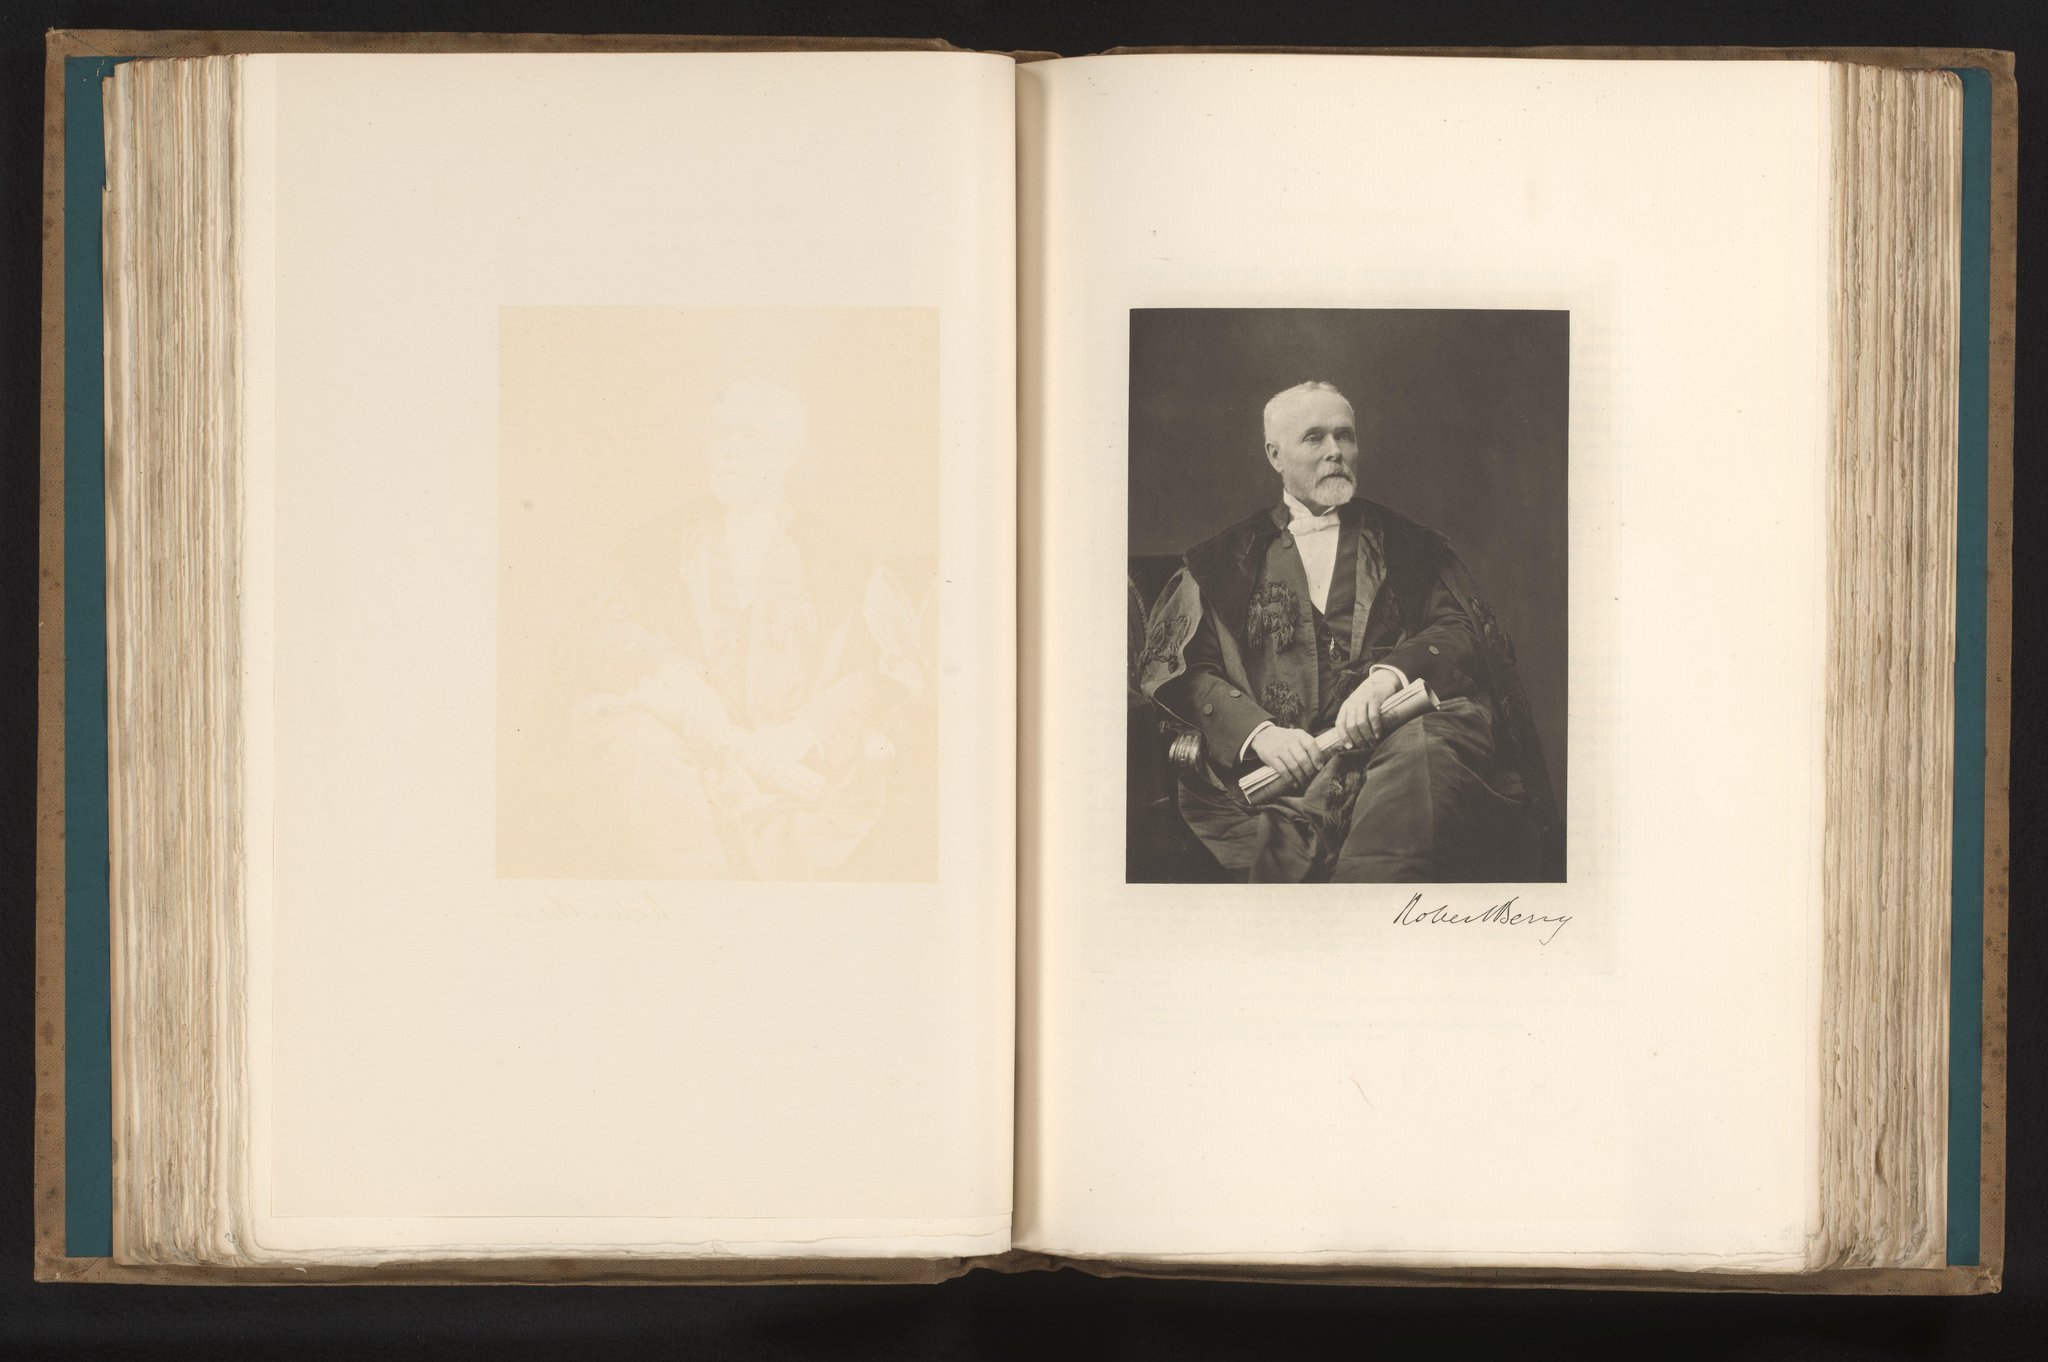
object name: photomechanical print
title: Robert Berry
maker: Anonymous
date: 1886-1891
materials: paper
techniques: photoaquatint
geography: glasgow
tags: historical persons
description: Prent op tweede ongenummerde pagina na pagina 13.